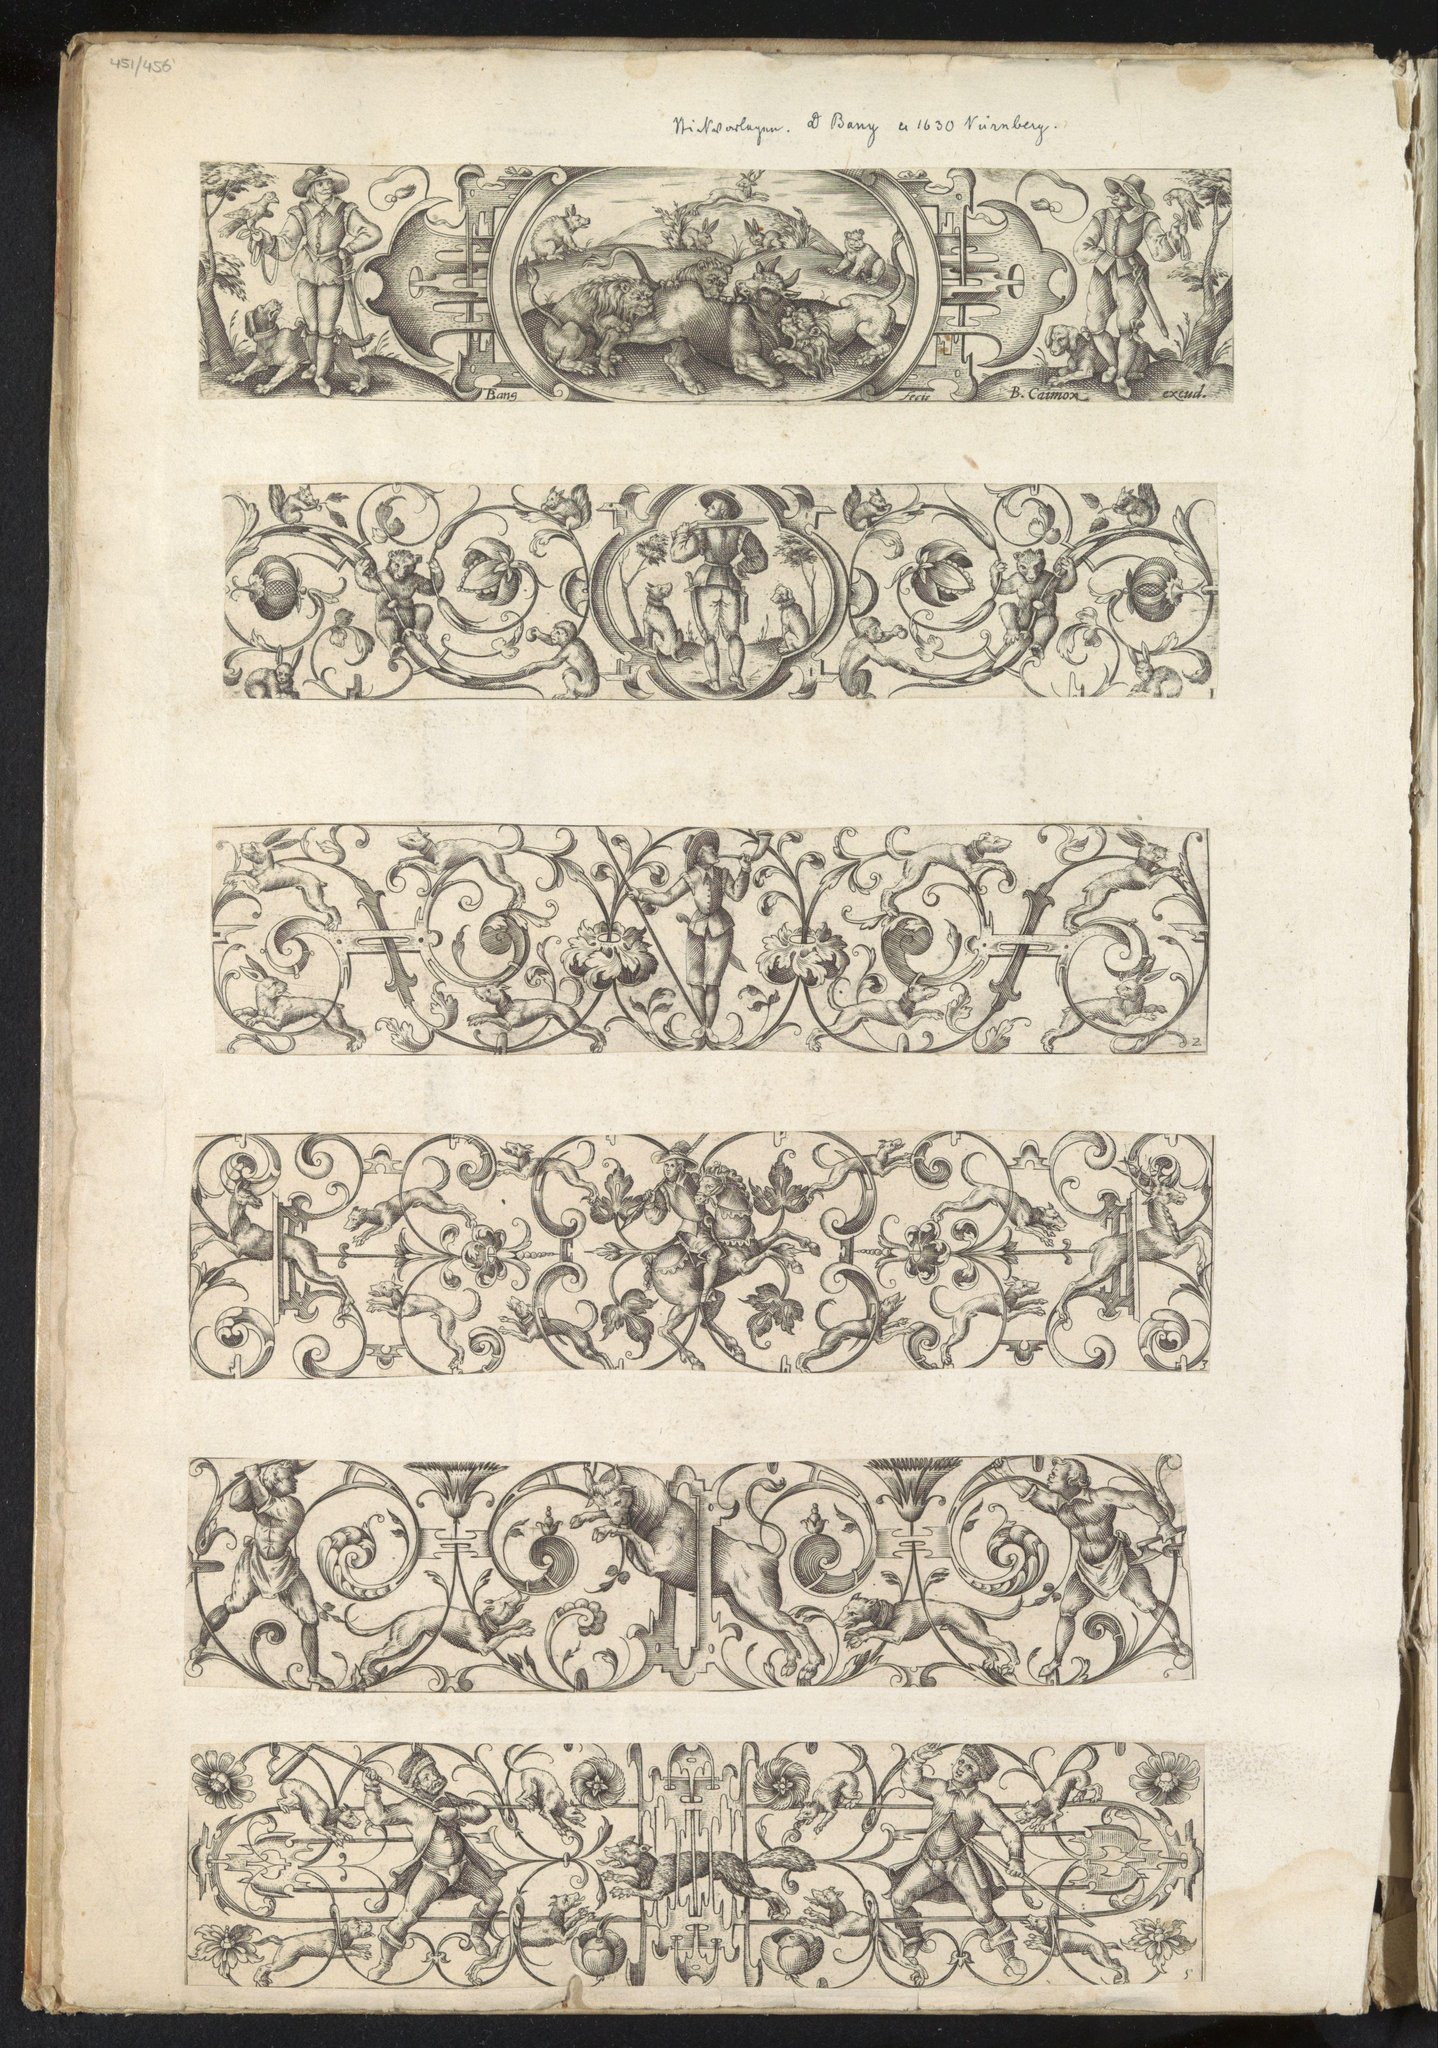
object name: print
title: Albumblad met zes ornamentprenten met dieren en jagers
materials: paper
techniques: engraving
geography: germany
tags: ornament ~ arabesque, hunting dogs, hunter, ornament ~ cartouche, hunt ~ mammals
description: Albumblad met zes uitgeknipte ornamentprenten met friezen met dieren en jagers tussen arabesken.